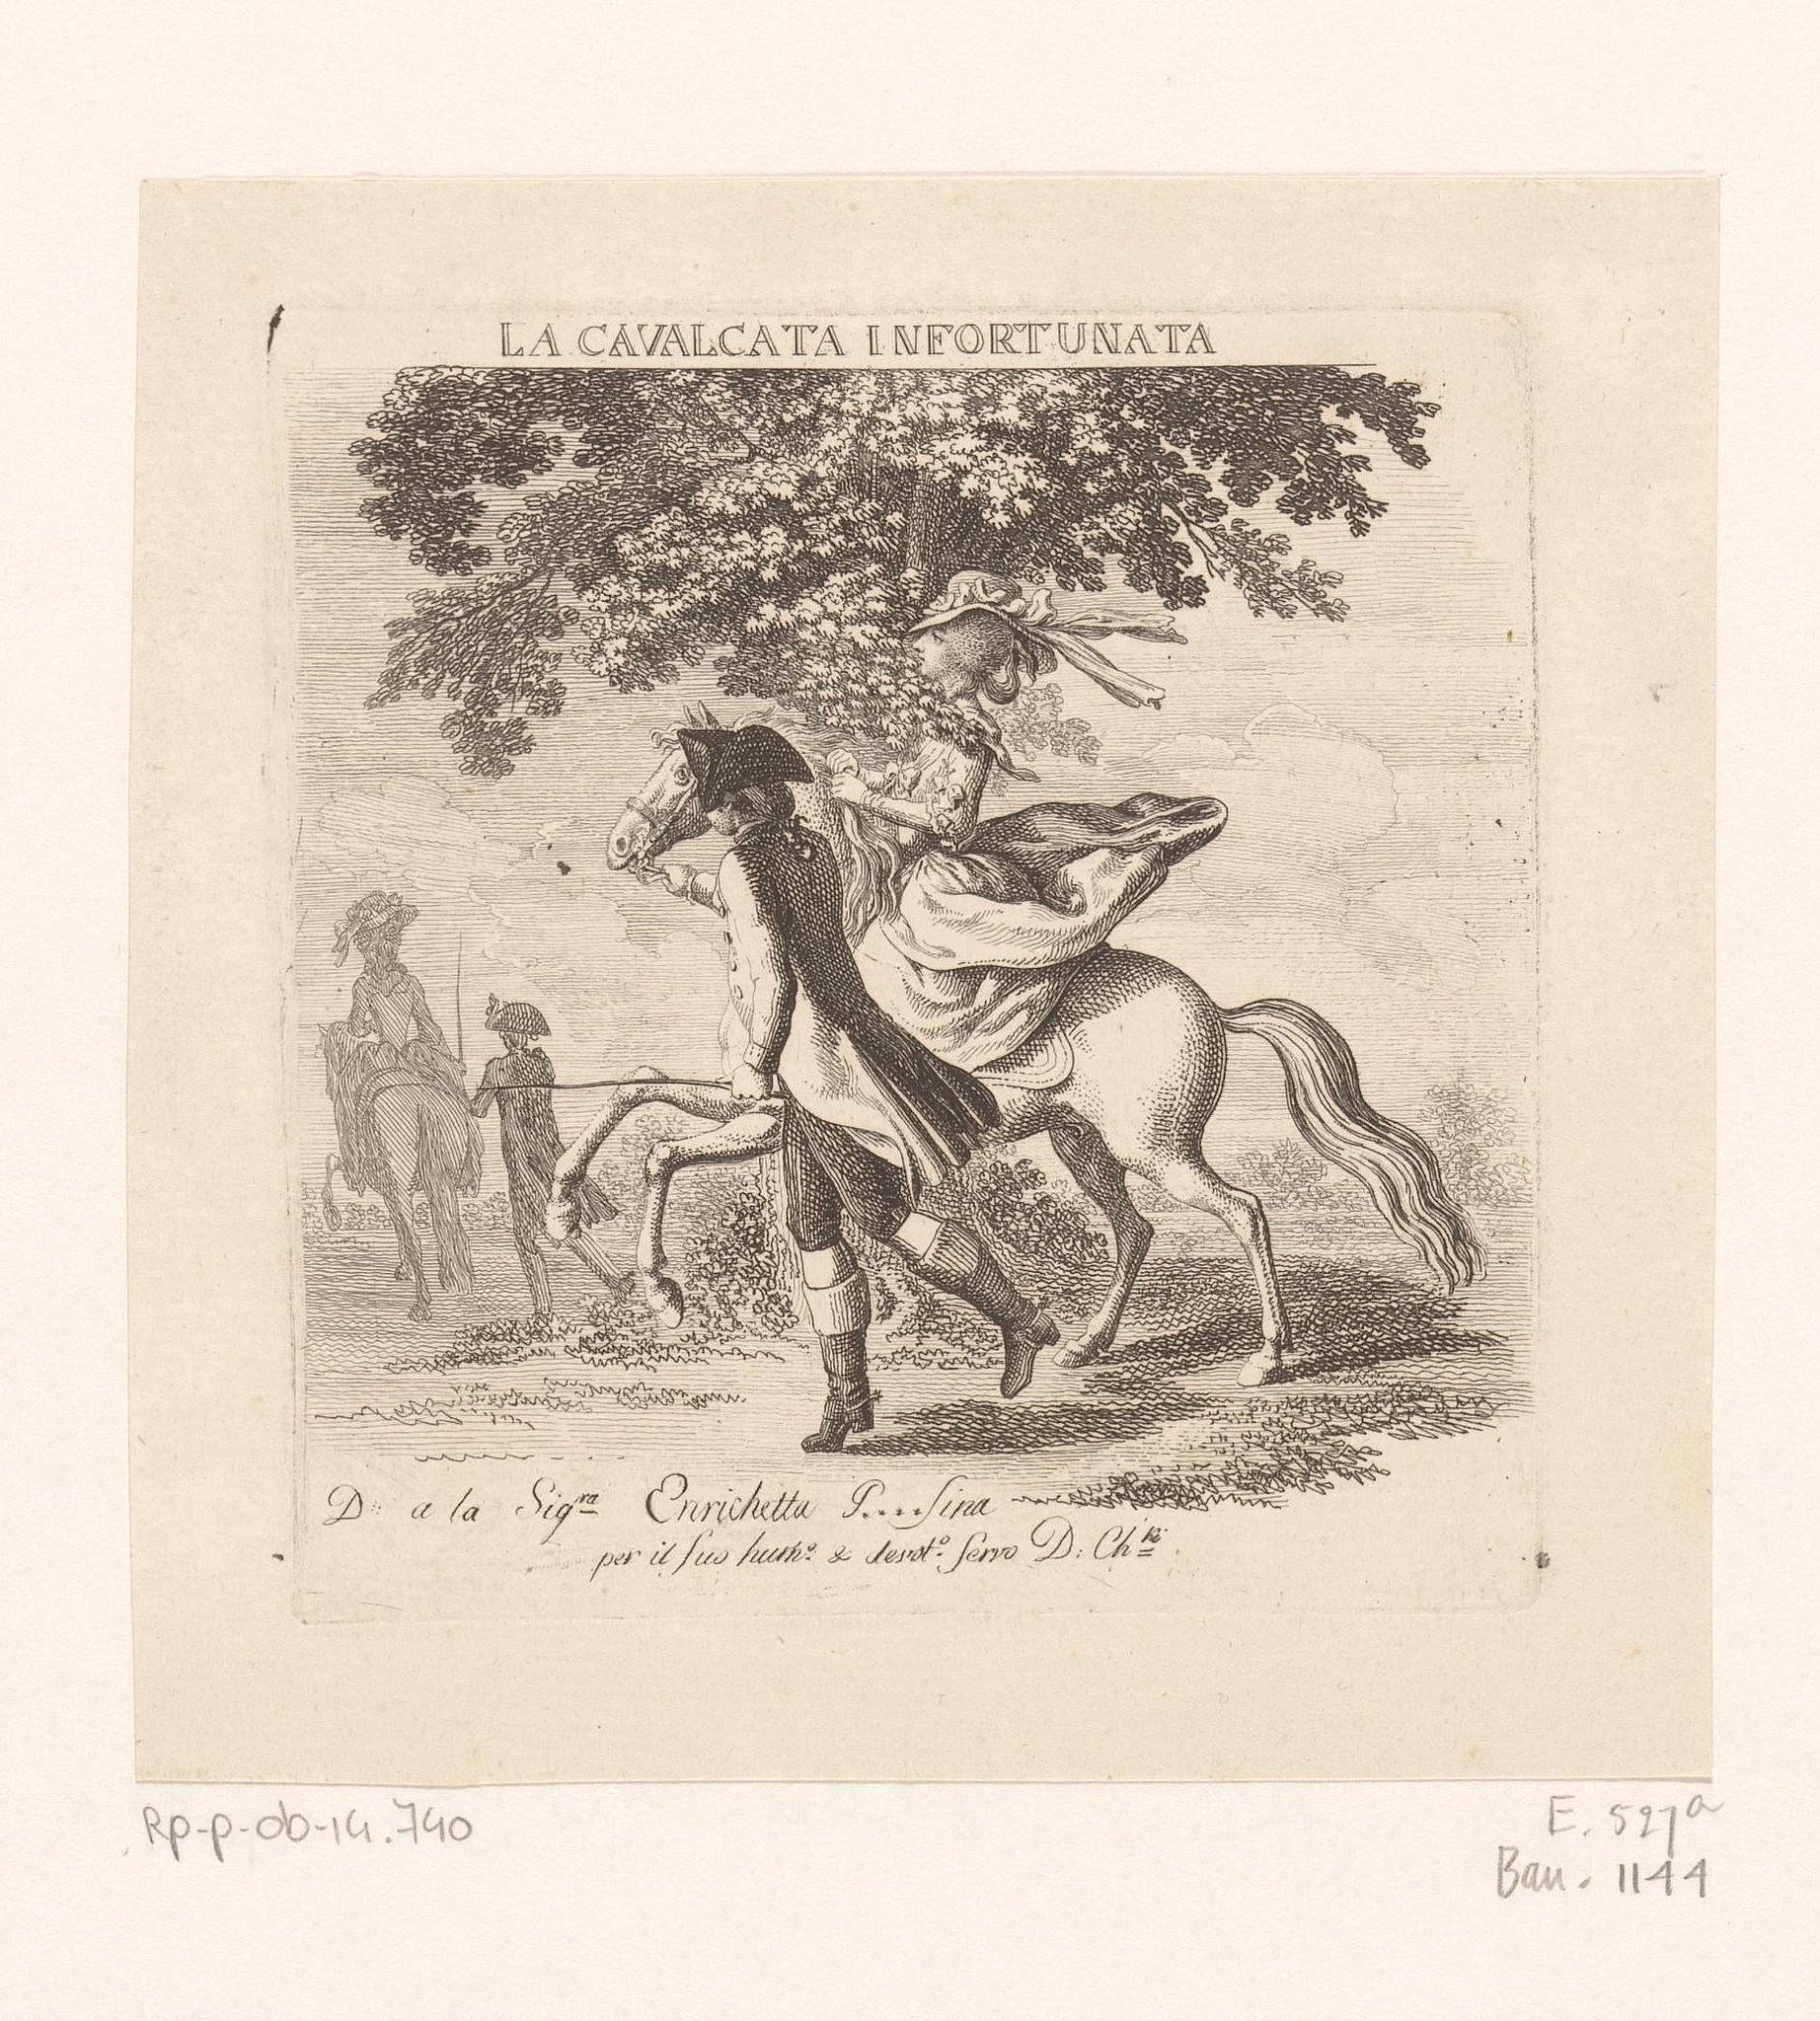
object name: print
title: La Cavalcata infortunata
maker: daniel nikolaus chodowiecki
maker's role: draughtsman, print maker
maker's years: 1726-1801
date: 1784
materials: paper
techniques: etching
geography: berlin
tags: riding a horse, ass, or mule; rider, horseman, riding-school, manège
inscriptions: collector's mark: Lugt 2228